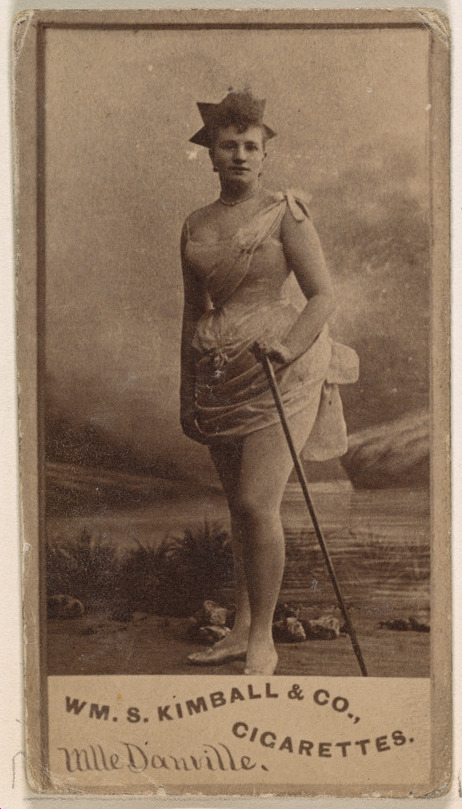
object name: photograph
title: Mlle Danville, from the Actresses series (N203) issued by Wm. S. Kimball & Co.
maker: william s. kimball & company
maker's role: publisher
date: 1889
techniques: color lithograph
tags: portraits,women,actresses